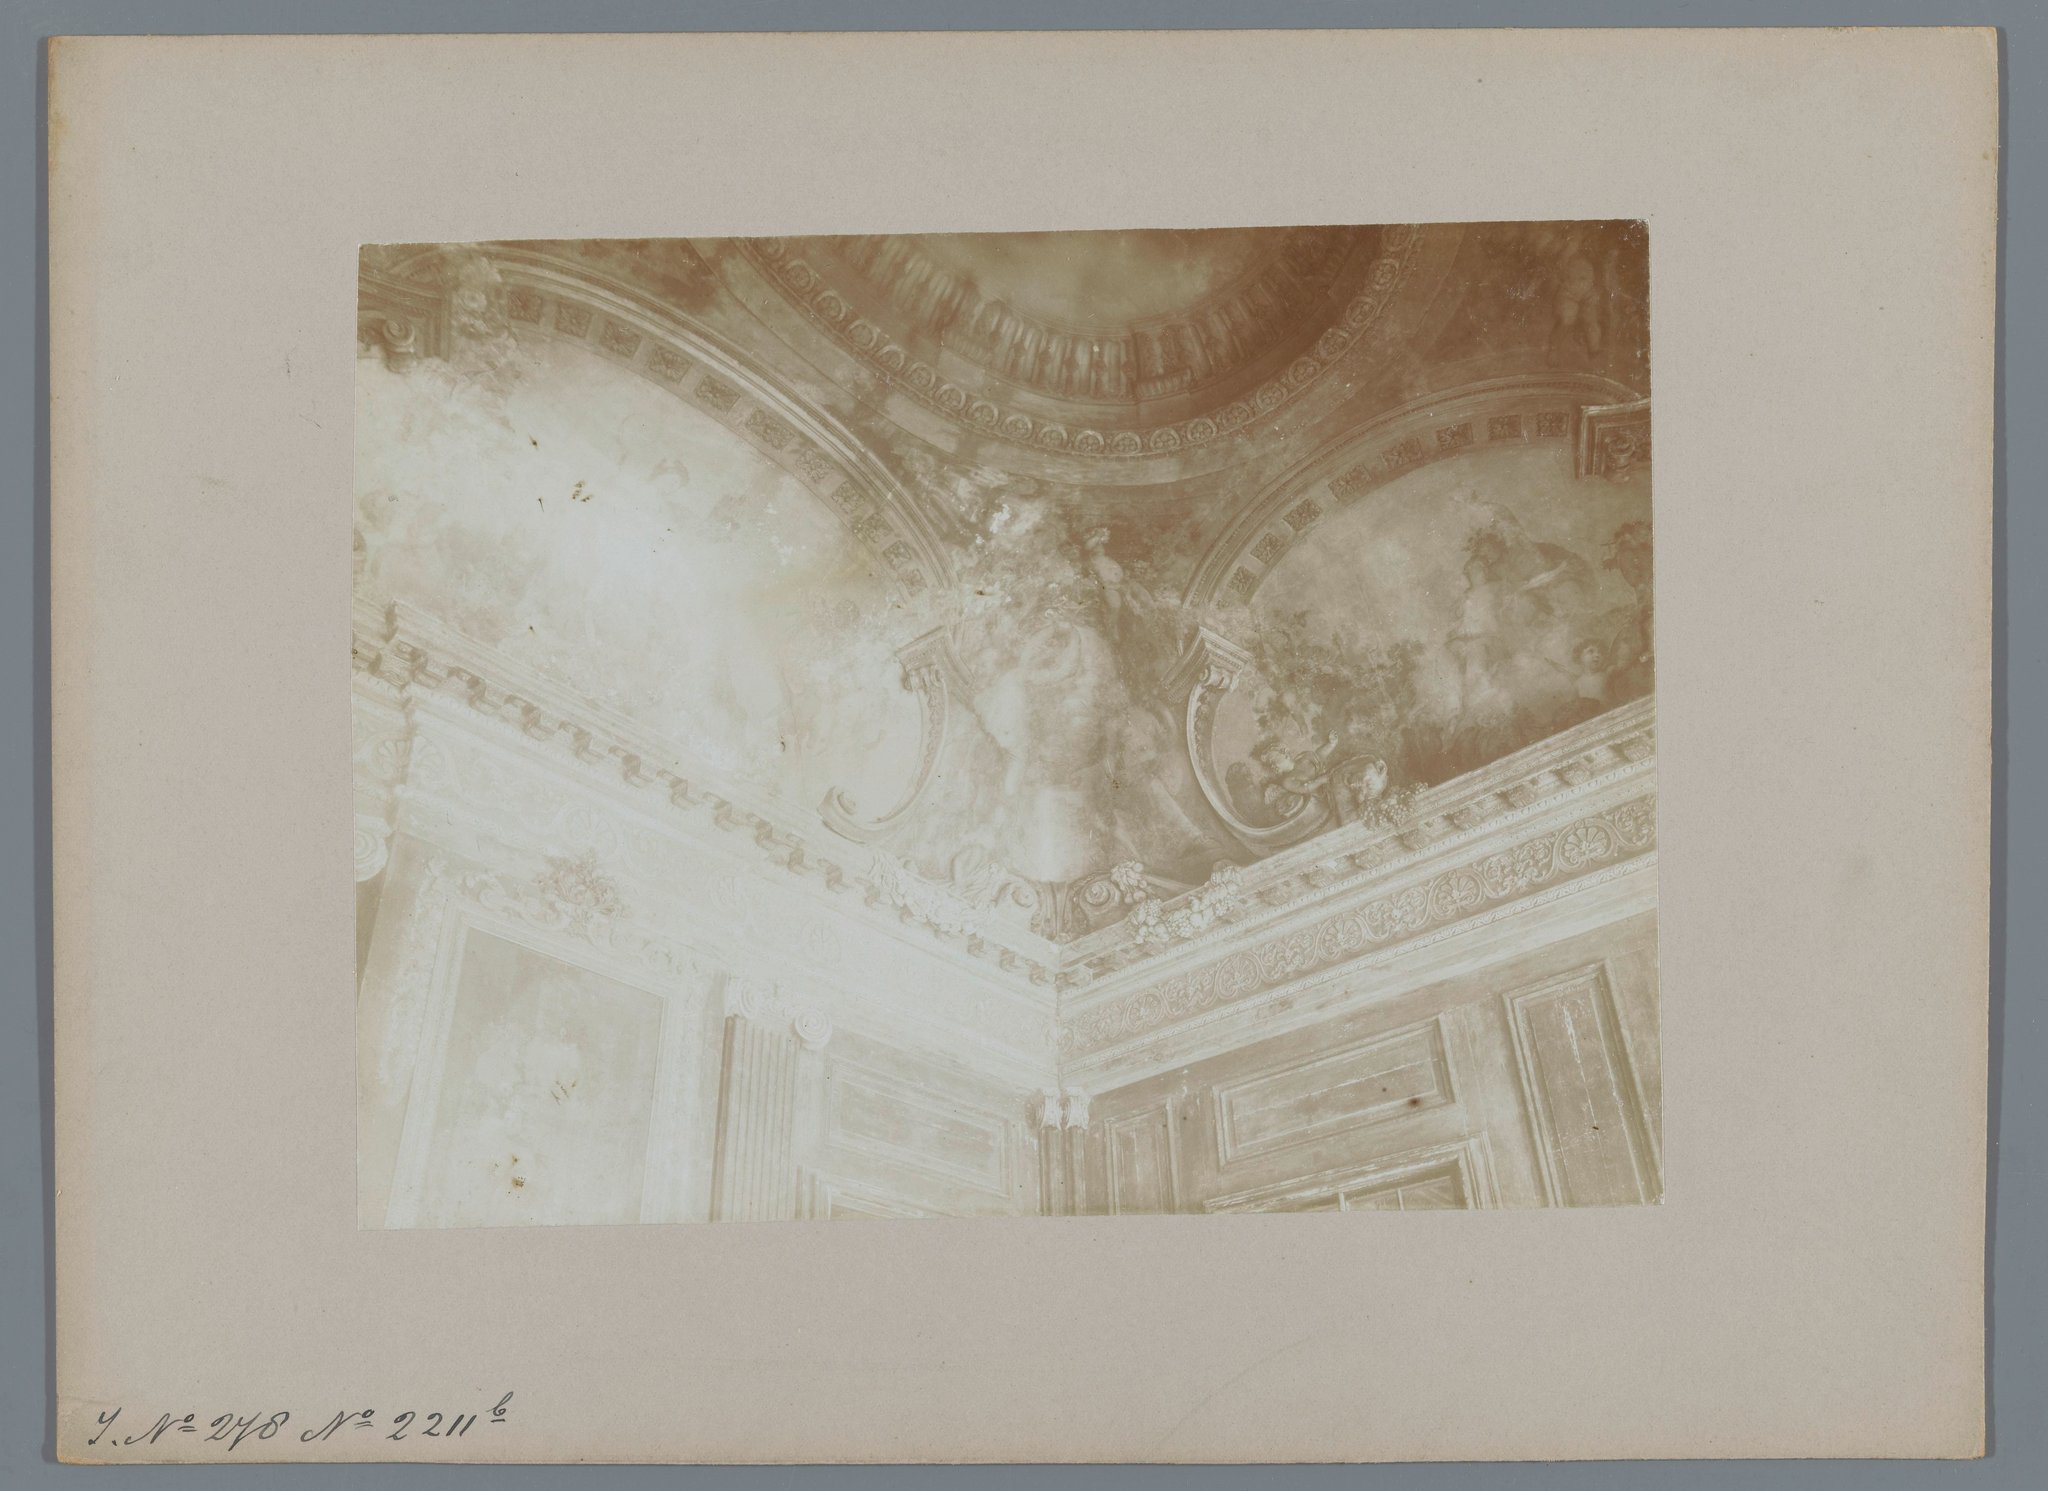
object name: photograph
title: Deel van een beschilderd koepelplafond in een huis aan het Noordeinde te Den Haag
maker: Anonymous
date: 1901-1912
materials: cardboard, photographic support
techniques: collodion silver print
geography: noordeinde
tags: (decorated) ceiling, interior ~ representation of a building, cupids: 'amores', 'amoretti', 'putti'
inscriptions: annotation, inscription: ‘Een der hoeken van het plafond. Koepel H voorm. huis Fagel Noordeinde den Haag Jan. 1912.’, inscription: ‘neg. no 15066 foto no 7292’